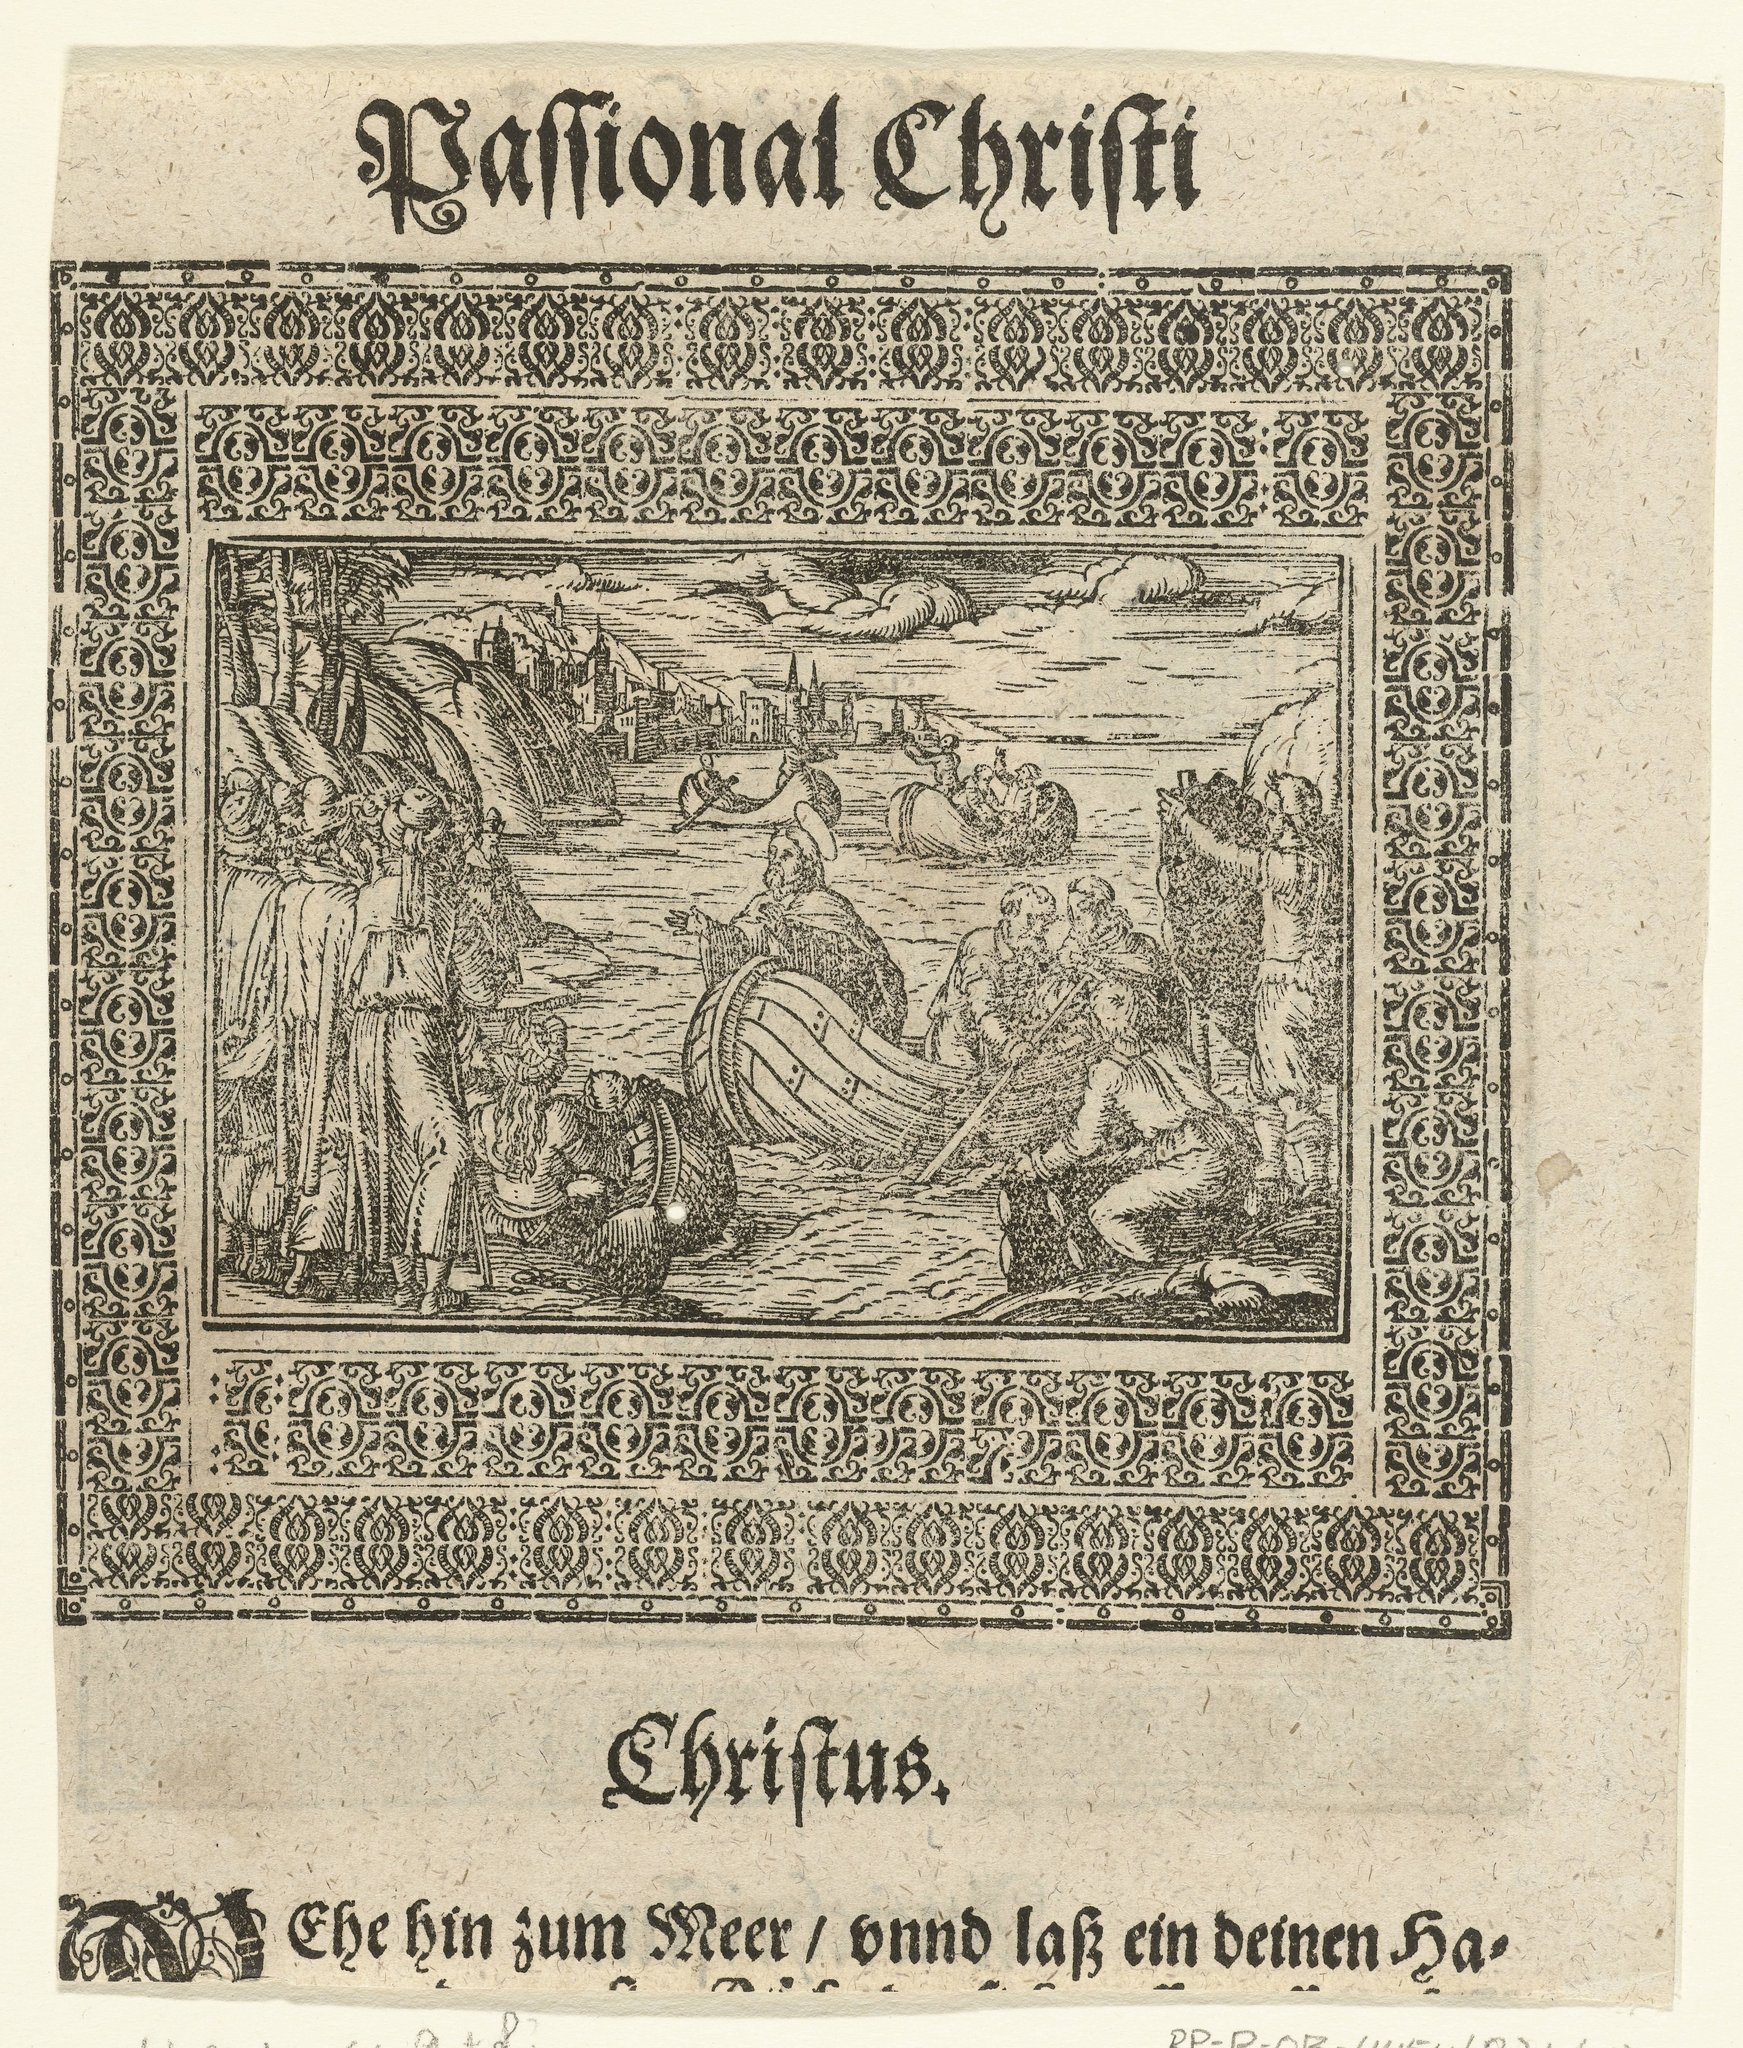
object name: book illustration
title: Wonderbare visvangst op meer van Galilee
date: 1521-1522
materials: paper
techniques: woodcut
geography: wittenberg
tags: the miraculous draught of fishes (before the resurrection) on the lake of gennesaret (sea of galilee); james and john helping to bring in the nets (luke 5:1-11)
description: De tegenhanger van deze prent is de voorstelling Paus spreekt banvloek uit over keizer, zie RP-P-OB-4455(V). Blad uit: Passional Christi und Antichristi, Wittenberg 1521-1522, Johann Grünenberg. In 1521-1522 verschenen veel verschillende uitgaven van dit populaire werk van Maarten Luther. In de collectie van het RMA bevindt zich de complete serie van zesentwintig afbeeldingen uit een van deze uitgaven. De pagina's zijn op een kleiner formaat gesneden, onder iedere voorstelling stond oorspronkelijk een aantal regels Duitse tekst. De bladen hebben allemaal op dezelfde plaats twee kleine gaatjes van vraat door ongedierte wat er op wijst dat ze behoren tot hetzelfde exemplaar. Deze afbeelding met het onderwerp de Wonderbare visvangst wordt niet bij Hollstein beschreven. De voorstelling vervangt een andere afbeelding in de oorspronkelijke reeks. De visvangst wijkt stillistisch af van de overige illustraties, het formaat is kleiner en op liggend formaat gedrukt. Mogelijk was Lucas Cranach (I) niet de prentmaker. De prent op het verso is overigens wel van zijn hand.